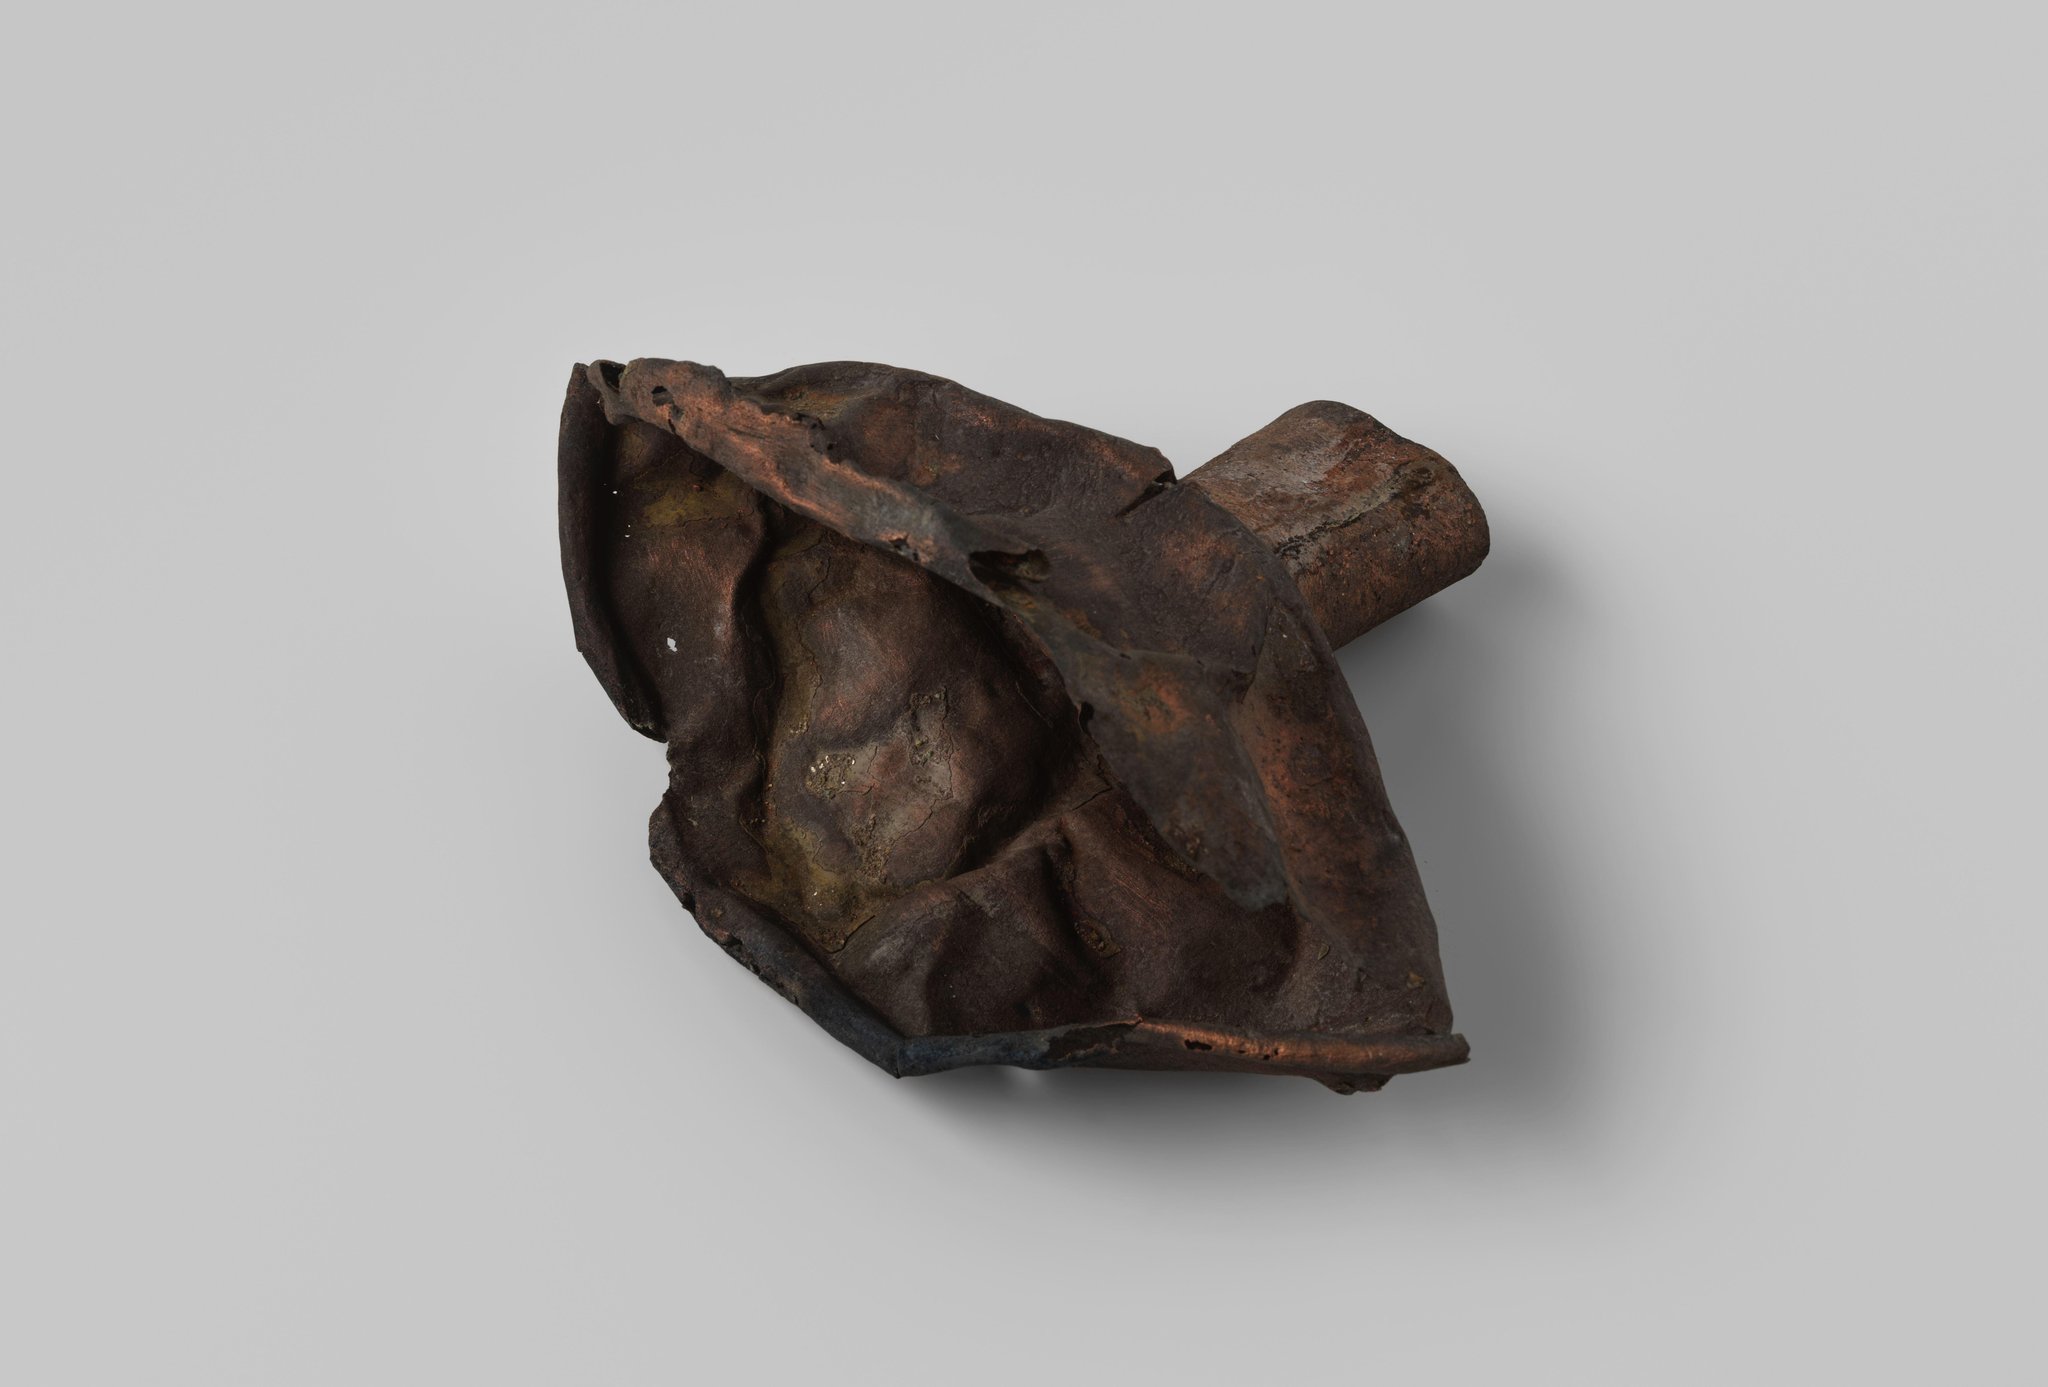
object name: funnel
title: Trechter uit het wrak van de Oost-Indiëvaarder Hollandia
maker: Anonymous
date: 1700-1743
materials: copper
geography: netherlands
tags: verenigde oostindische compagnie, hollandia (schip), annet